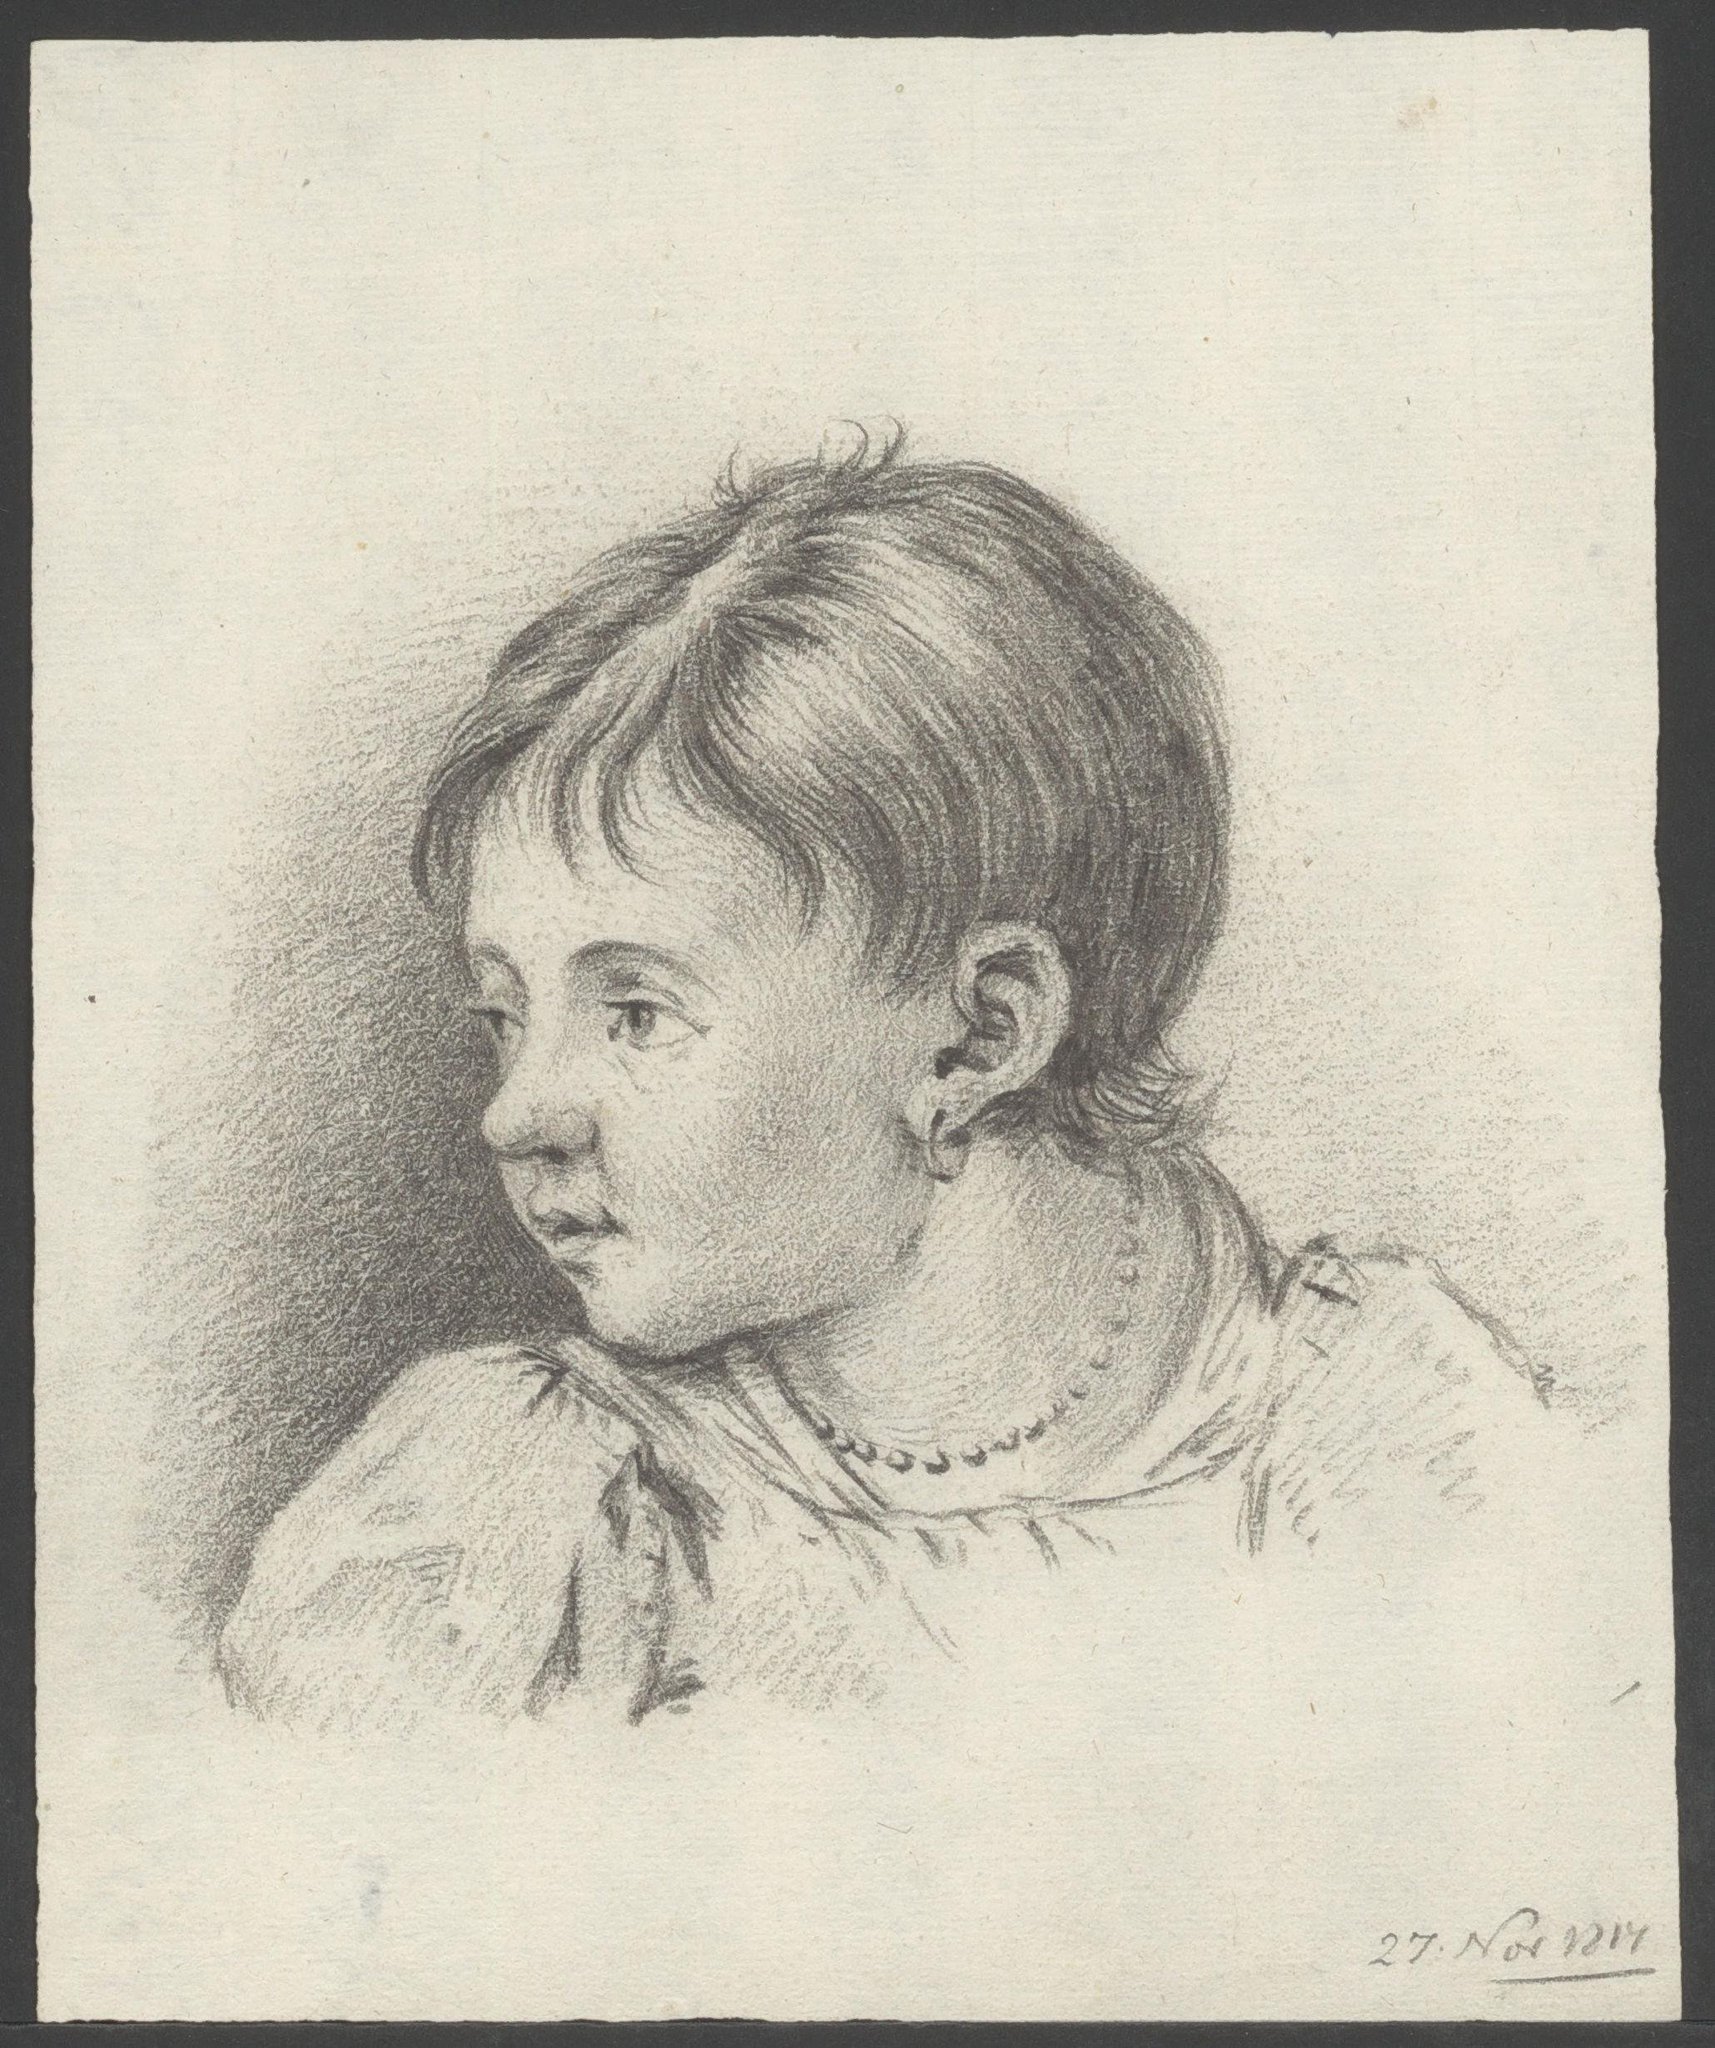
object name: drawing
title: Gezicht van een jong meisje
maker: jean bernard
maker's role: draughtsman, print maker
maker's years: 1765-1833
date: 1814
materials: chalk, paper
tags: girl (child between toddler and youth), ear-rings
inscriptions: collector's mark: Lugt 1641, stamp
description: Gezicht van een jong meisje, mogelijk familie van de kunstenaar. Onderwerpsrubrieken binnen de Atlas Zeden en Gewoonten: Schoone kunsten, Schilderkunst, Tekeningen.